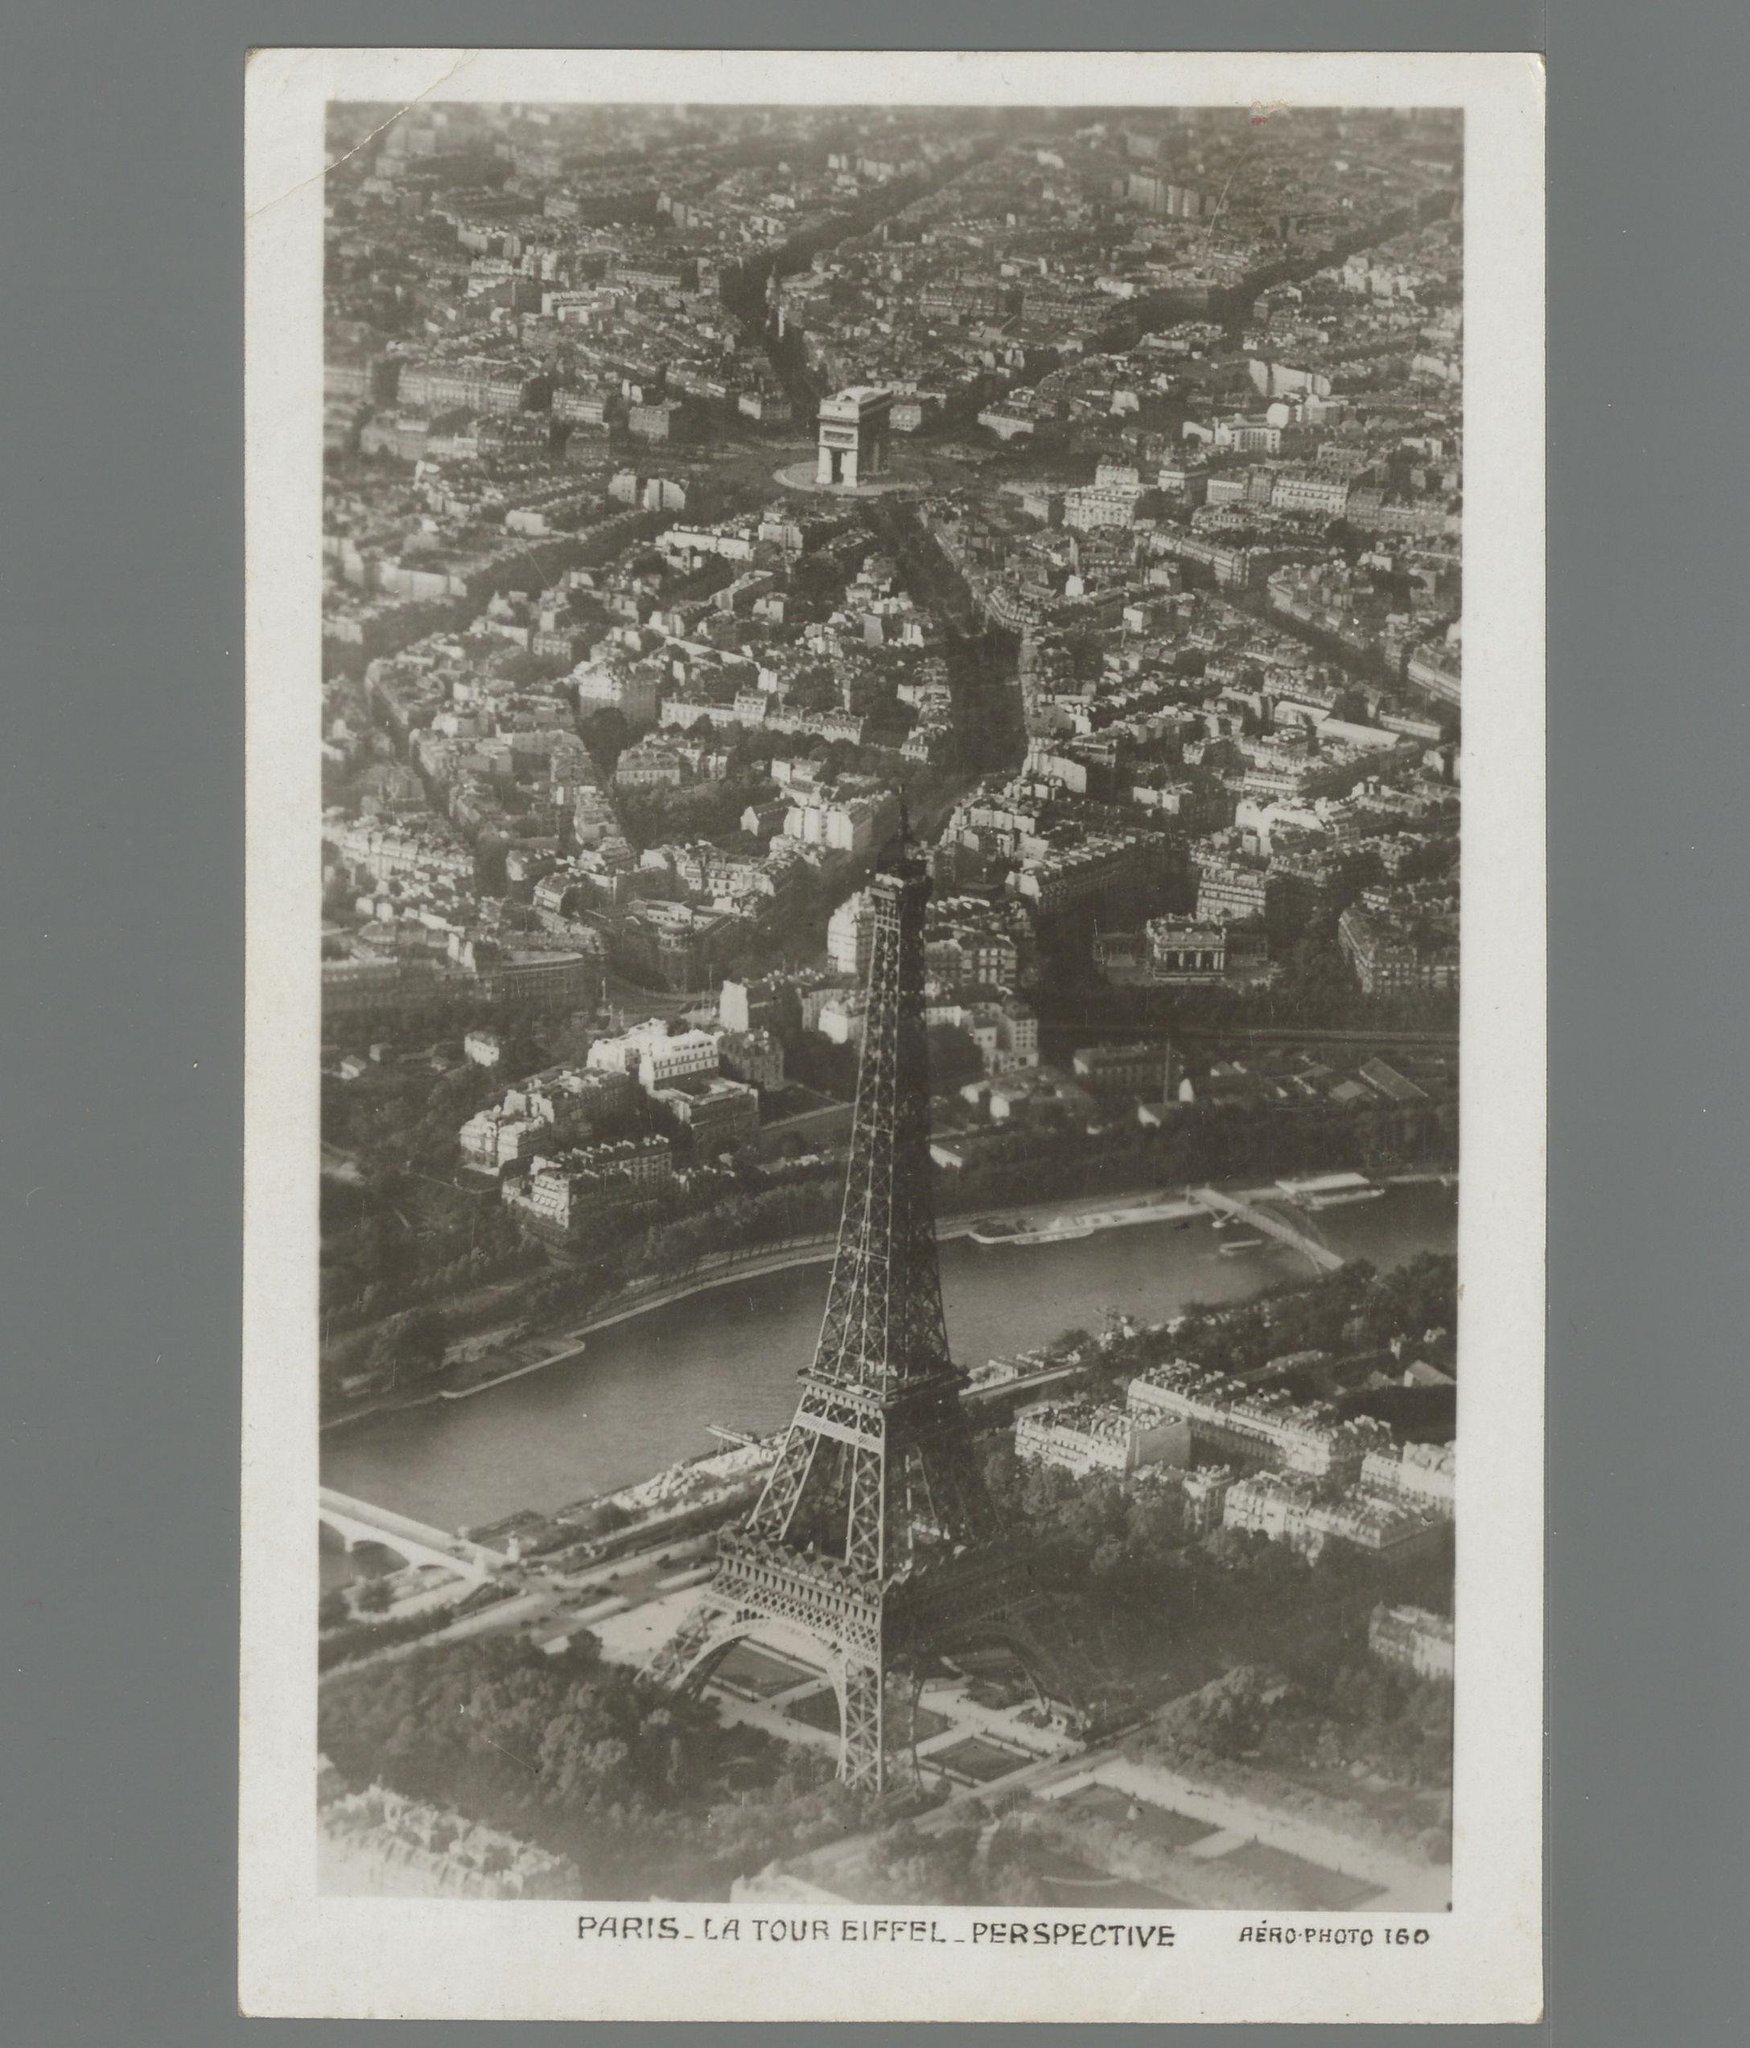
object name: ansichtkaart, prentbriefkaart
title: Paris - La Tour Eiffel - Perspective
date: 1903-1930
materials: photographic support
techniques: photography, writing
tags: city-view, and landscape with man-made constructions, canals, waters (in city), names of historical buildings, sites, streets, etc., paris, eiffel tower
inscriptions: postage stamp